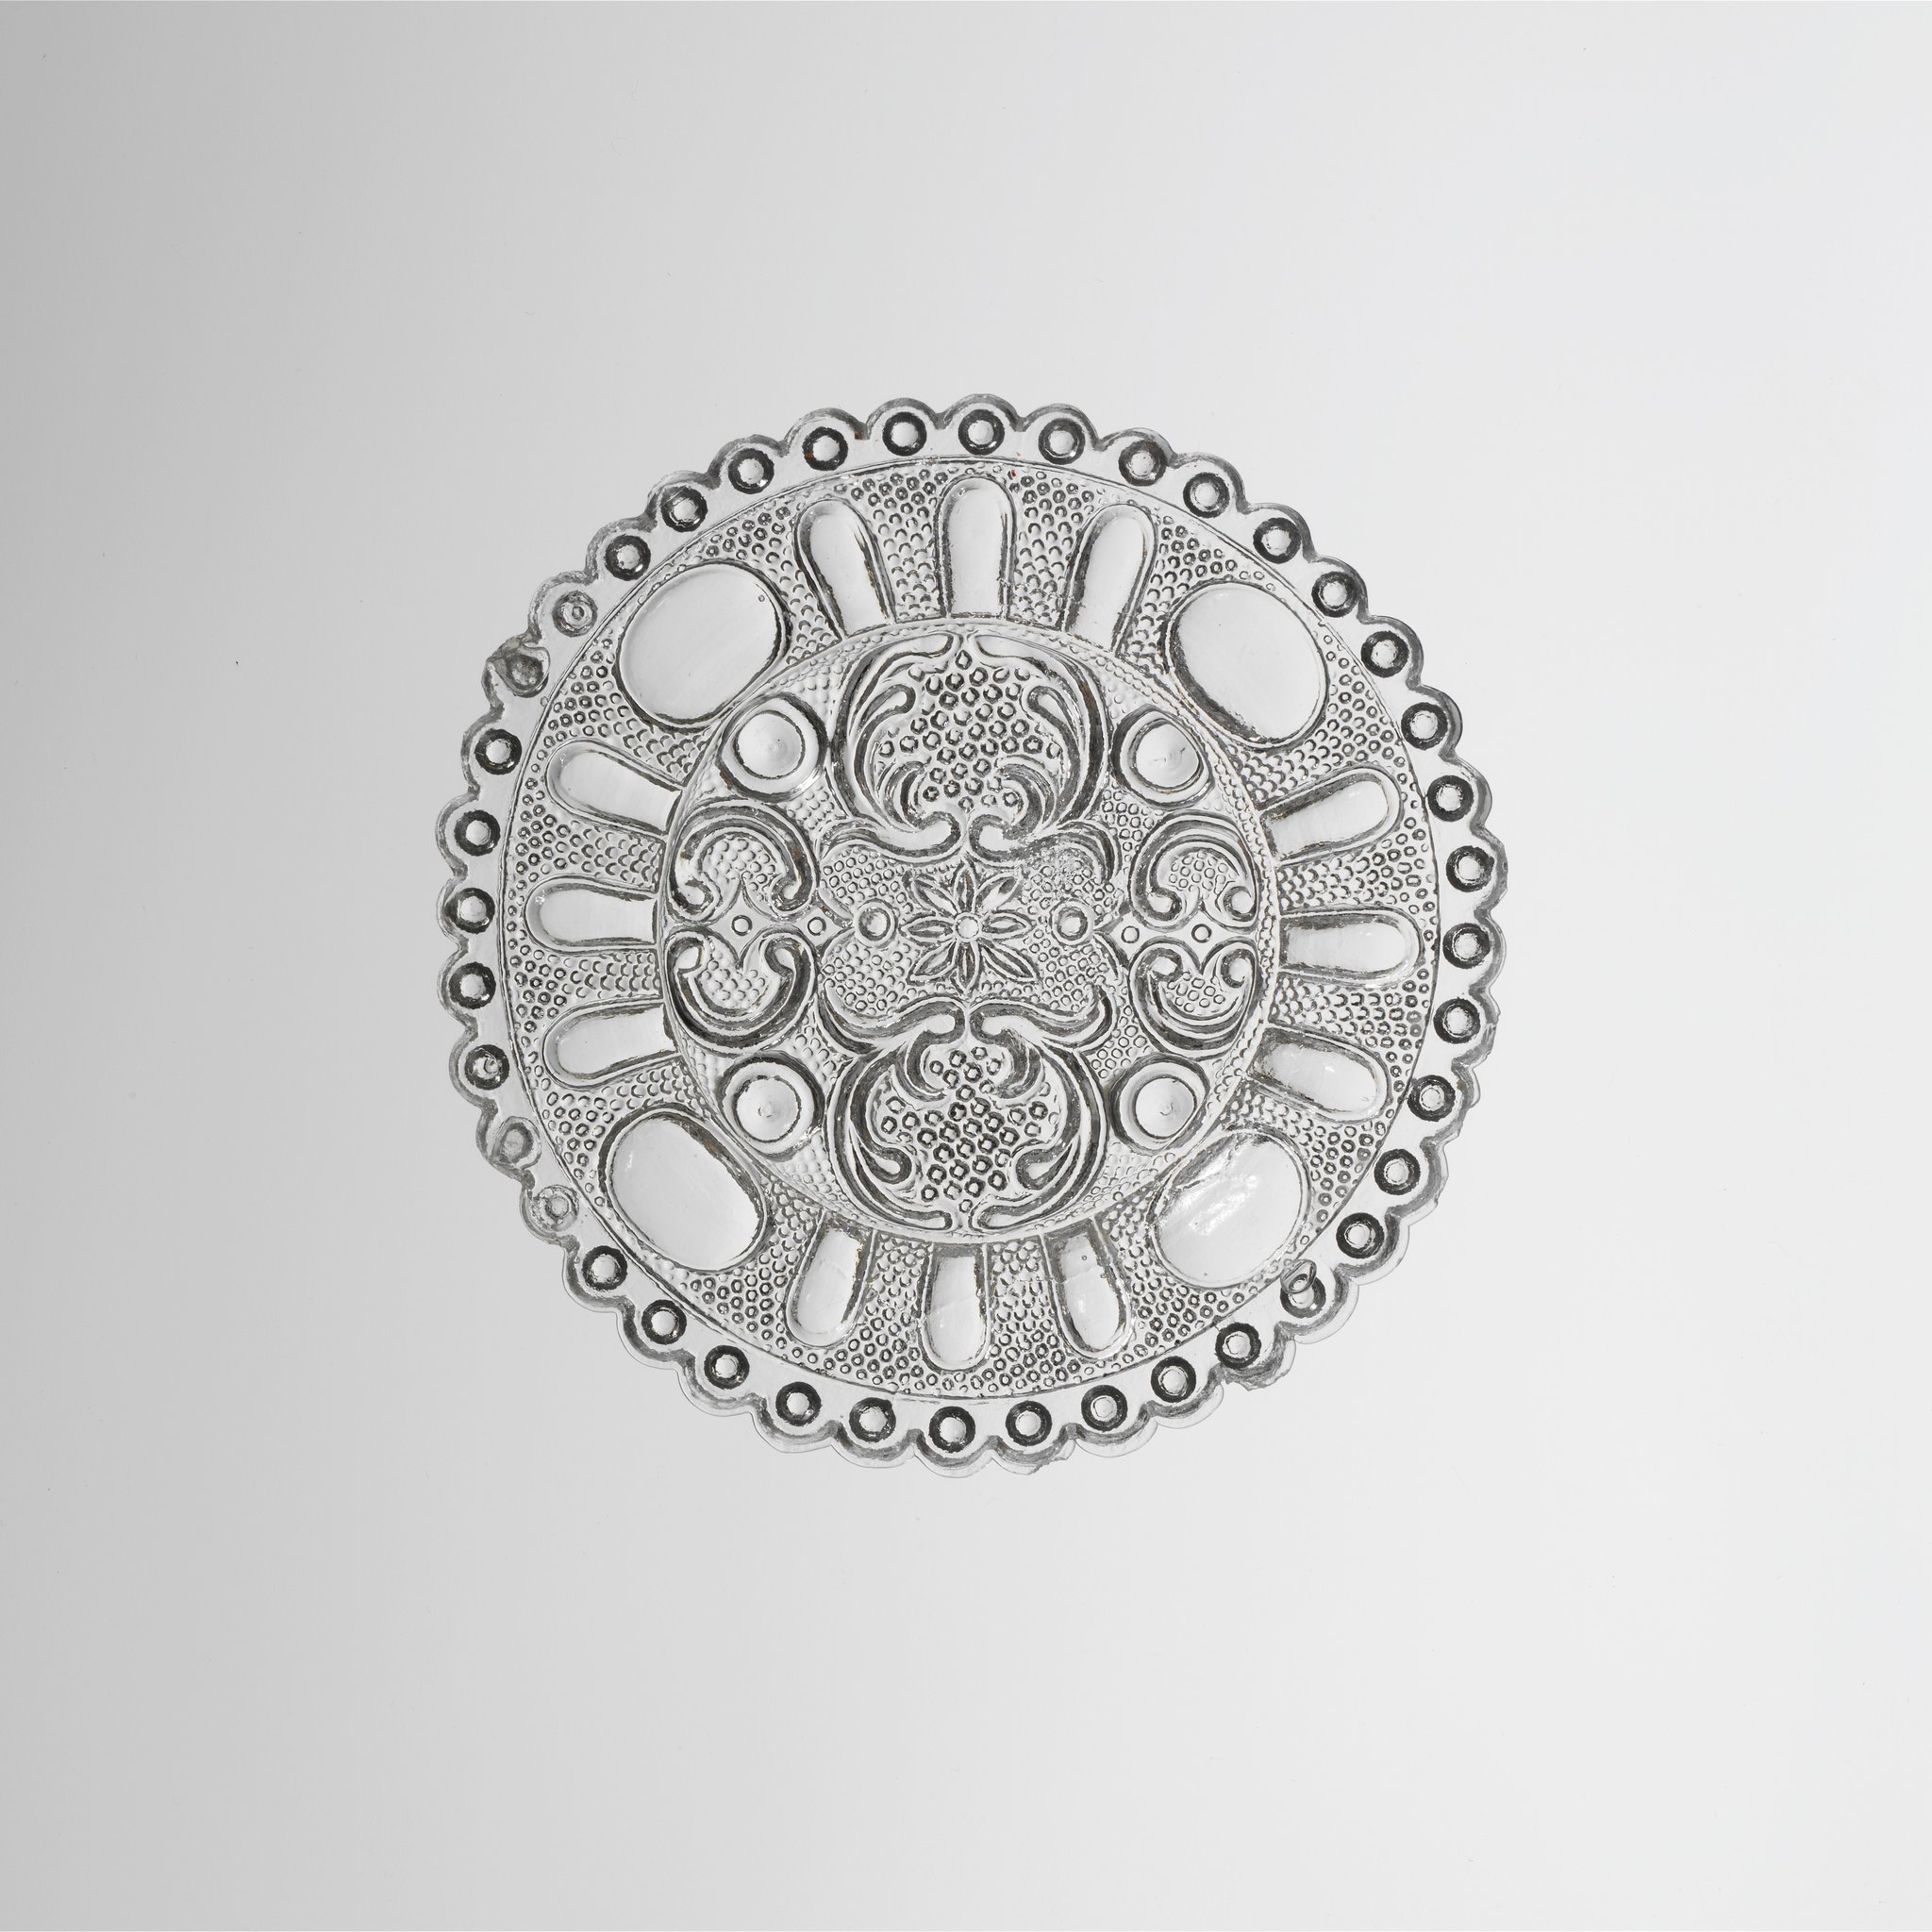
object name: cup plate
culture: american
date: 1825-1860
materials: glass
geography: united states